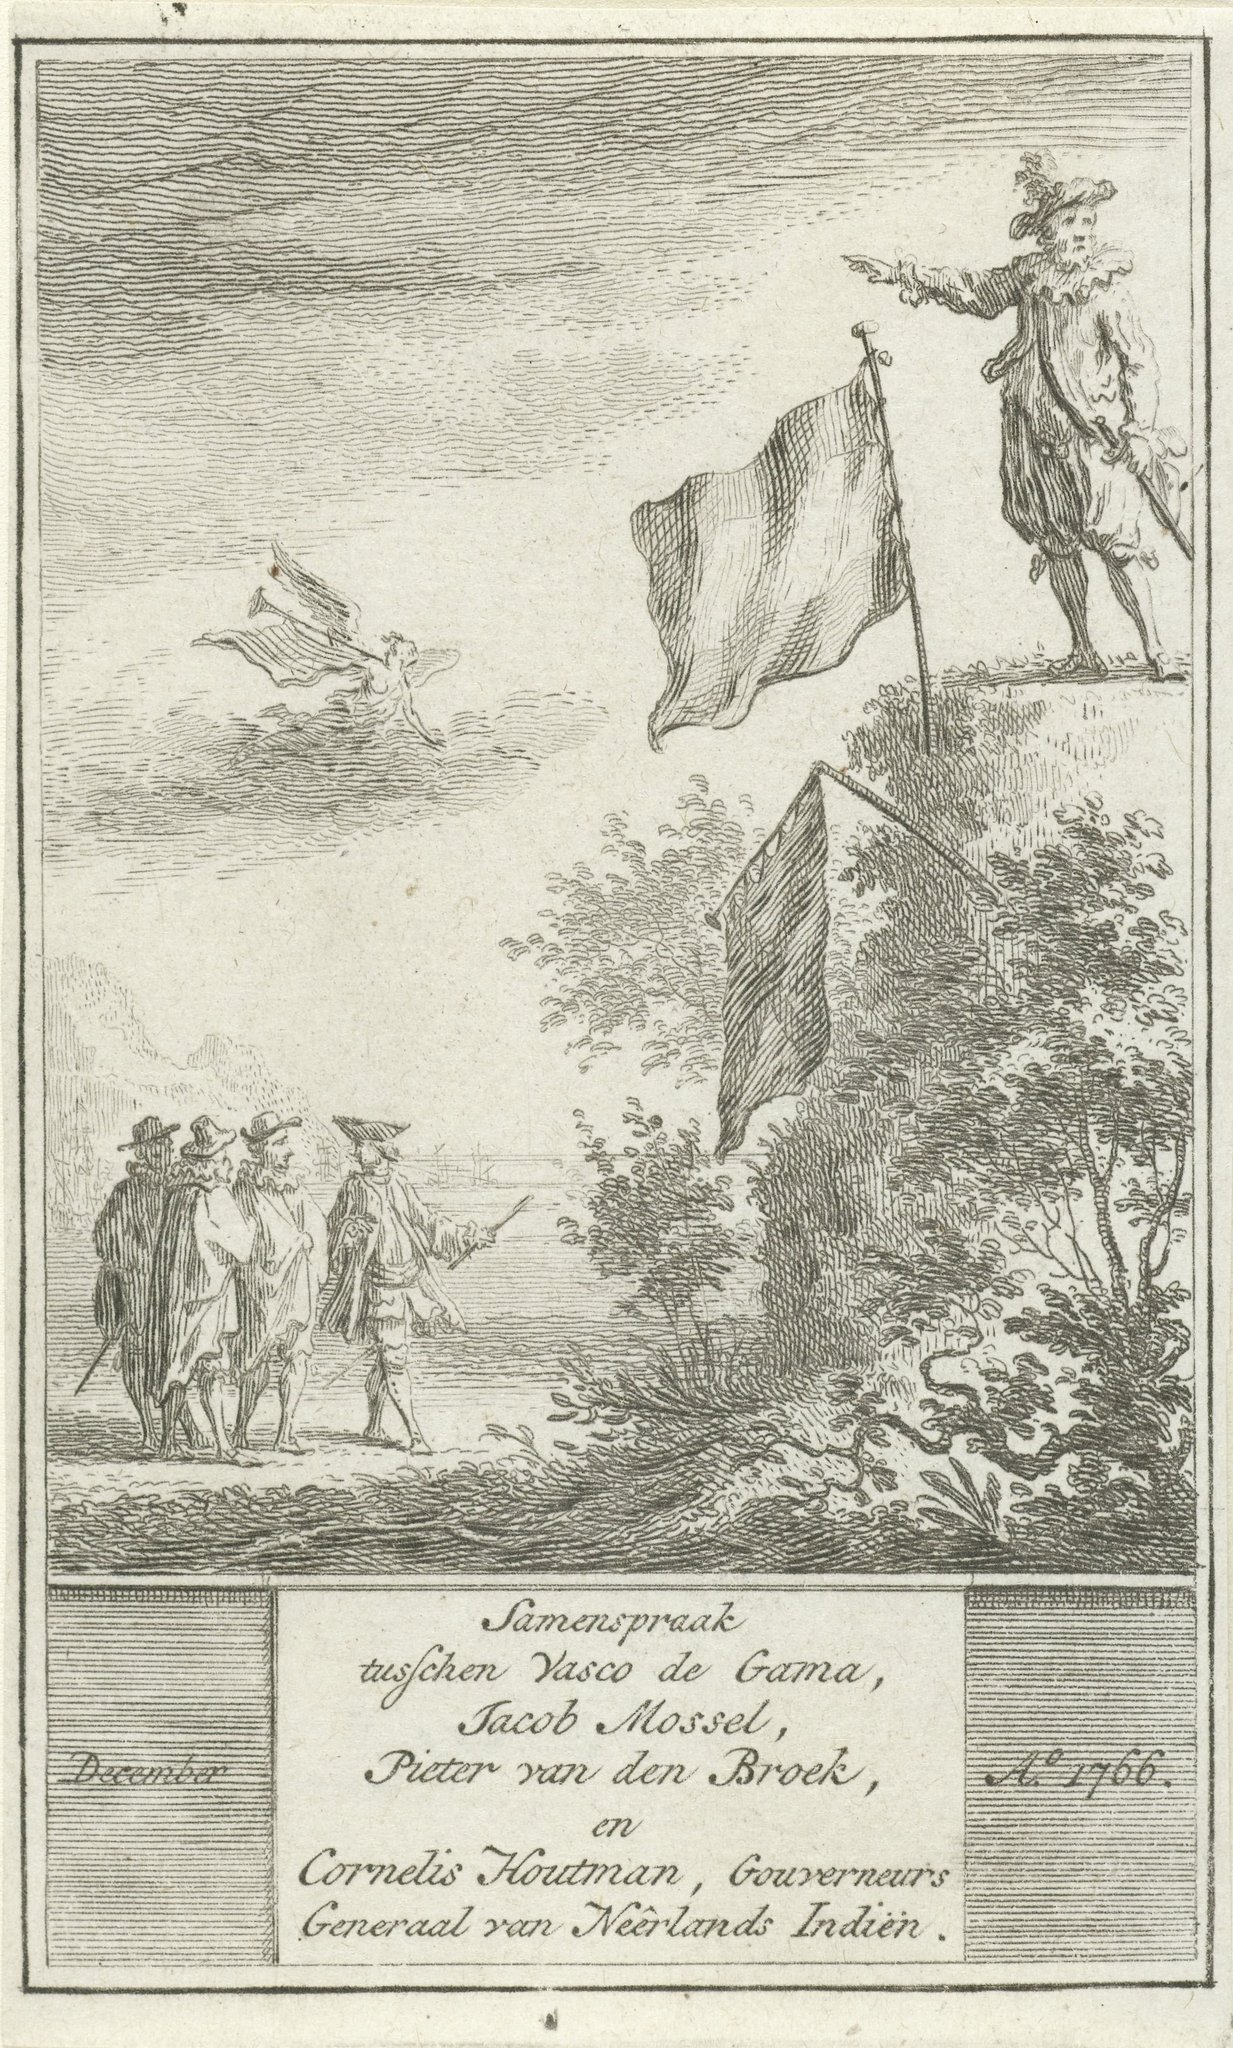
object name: book illustration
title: Vier historische figuren in gesprek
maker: simon fokke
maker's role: draughtsman, print maker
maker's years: 1712-1784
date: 1722-1784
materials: paper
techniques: etching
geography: amsterdam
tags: gouda, batavia, antwerp, pieter van den broecke, horn, trumpet, cornet, trombone, tuba, activities of angels (in heaven)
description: Gesprek in de buitenlucht tussen Vasco da Gama, Jacob Mossel, Pieter van den Broecke en Cornelis de Houtman. Hierboven vliegt een engel die de bazuin blaast. Een man bovenop een rotswand heeft de Hollandse vlag in de grond gestoken. De vlag die eronder hangt is geknakt. Onder de afbeelding een tekst met de datum december 1766.